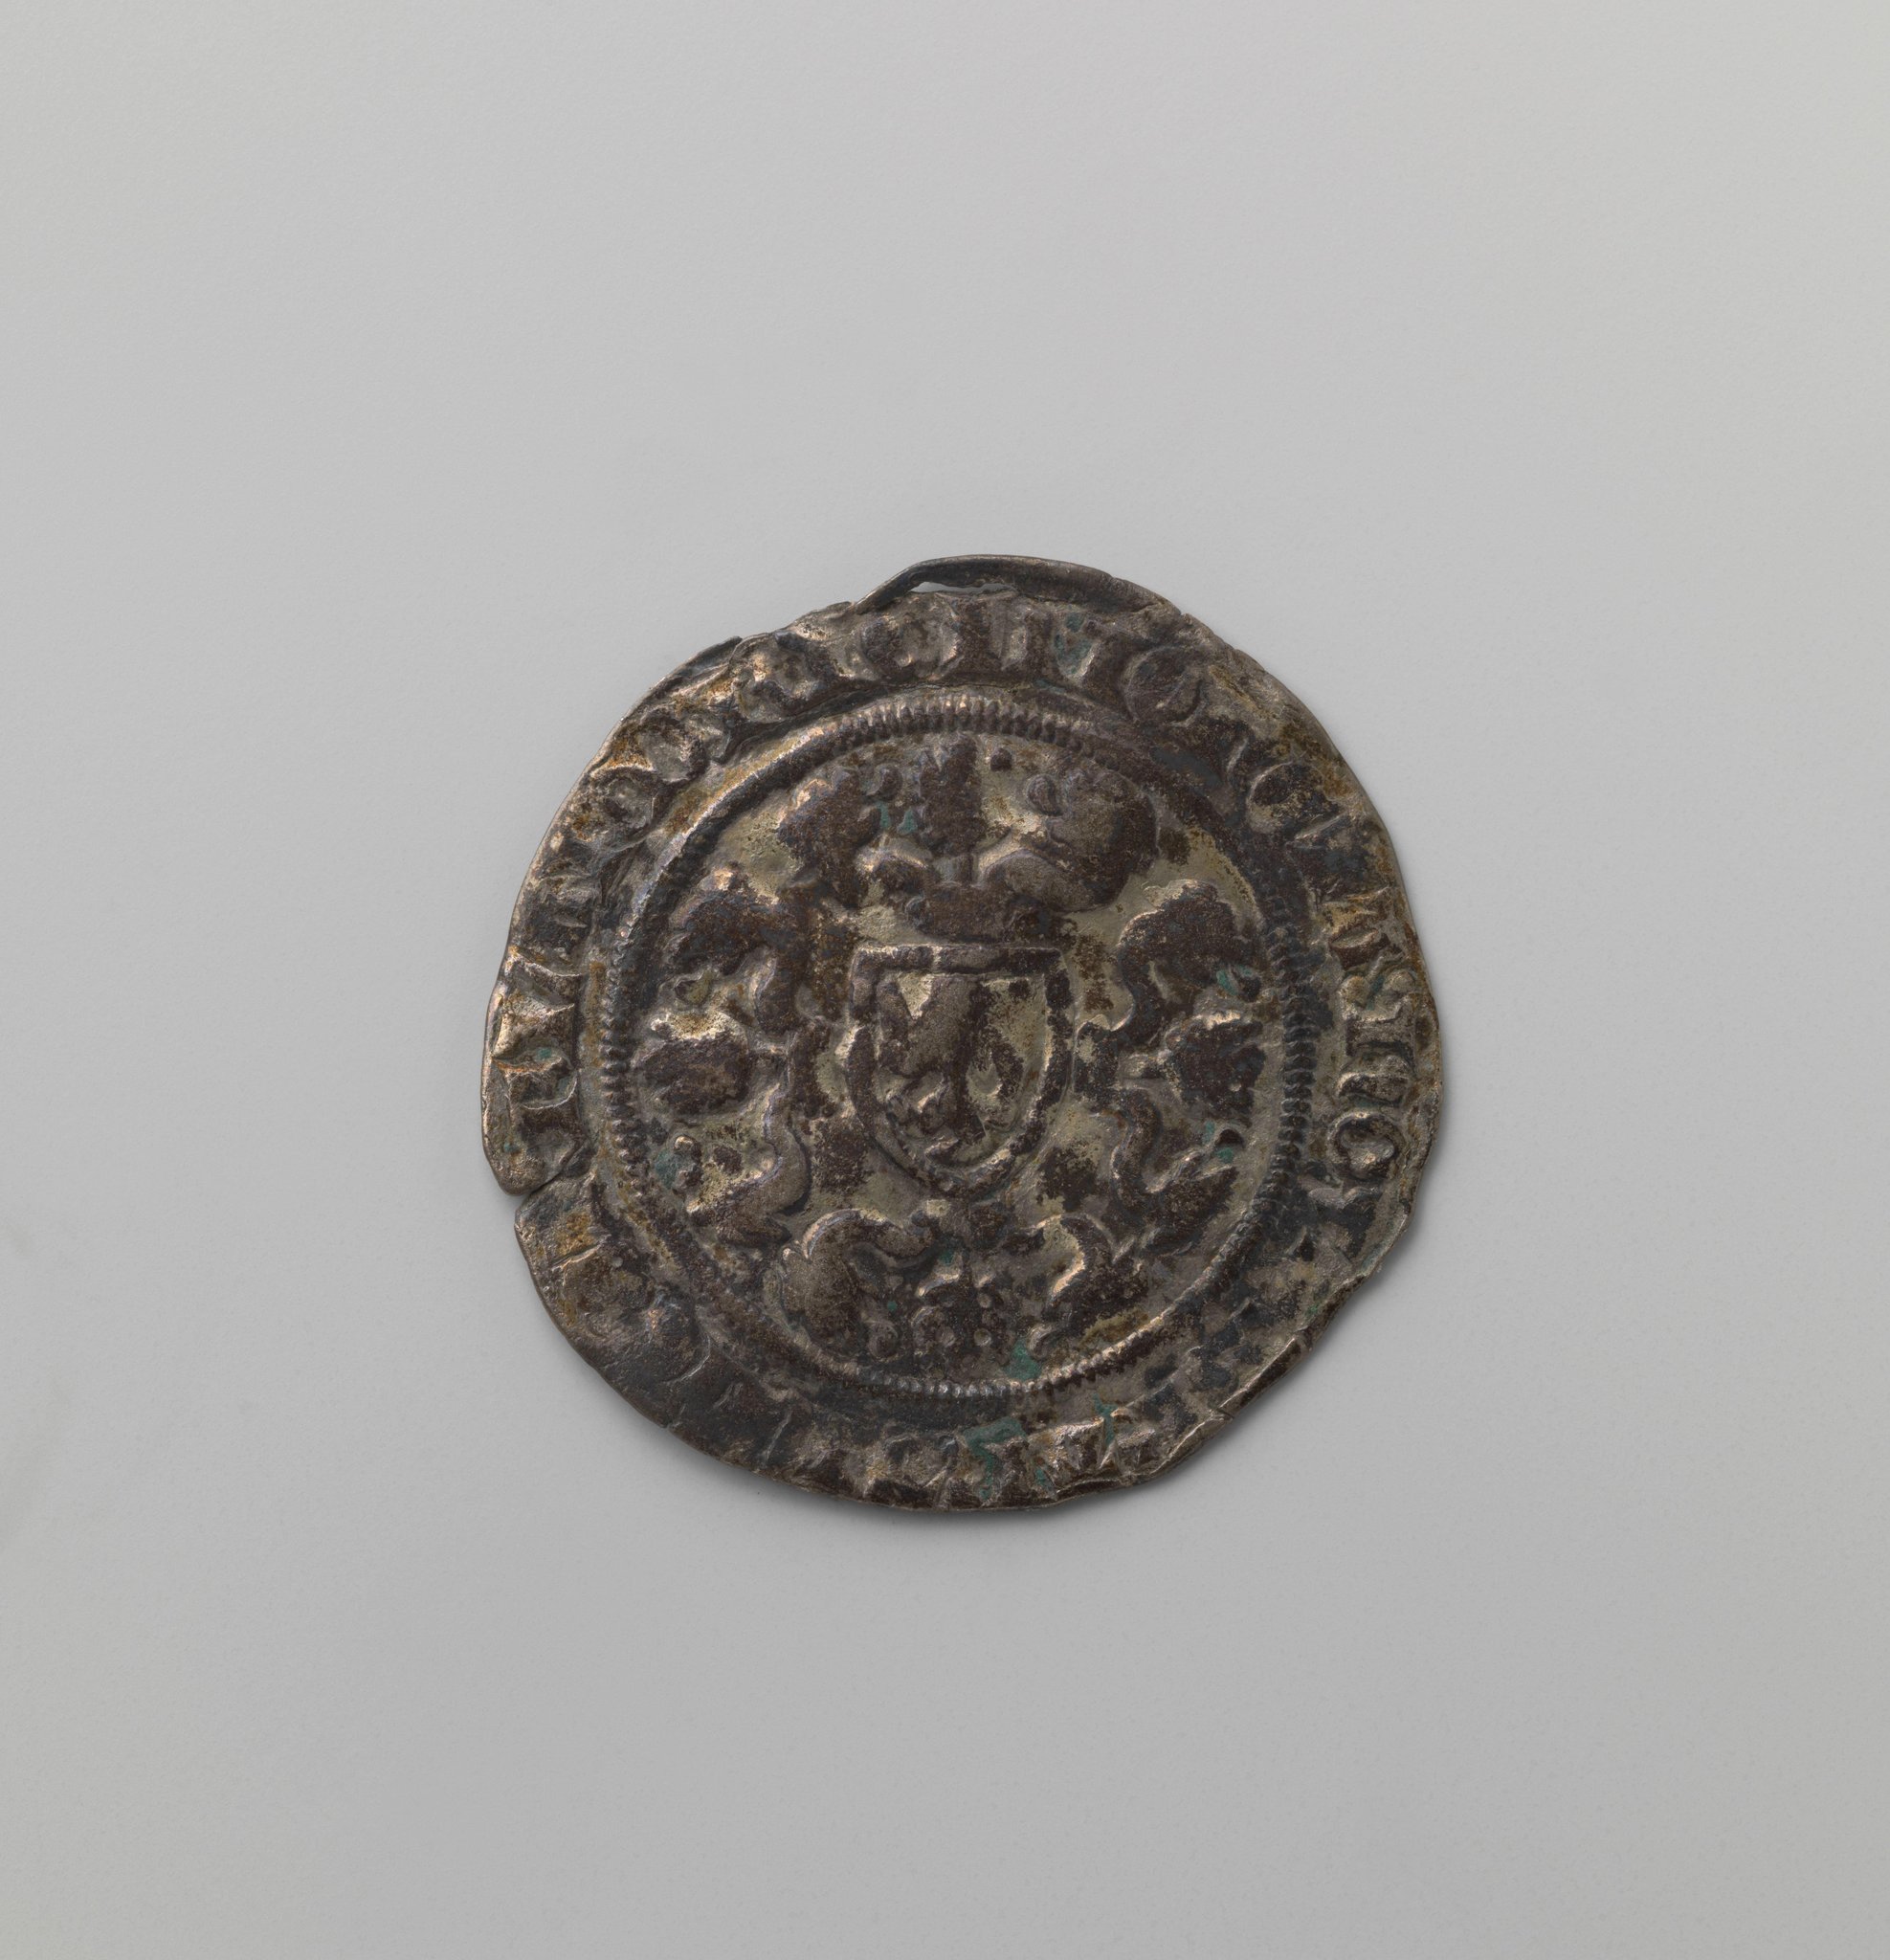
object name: coin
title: Halve groot rozebeker uit Brabant van Johanna en Philips de Stoute, graaf van Vlaanderen, 1384-1389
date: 1384-1389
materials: silver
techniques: striking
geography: leuven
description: Zilveren munt. Conventie-munt. Voorzijde: twee naast elkaar geplaatste wapenschilden, van Johanna en van Philips. Daarboven krans en daaromheen drie rozen. Keerzijde: wapenschild van Brabant op kort gebloemd kruis.